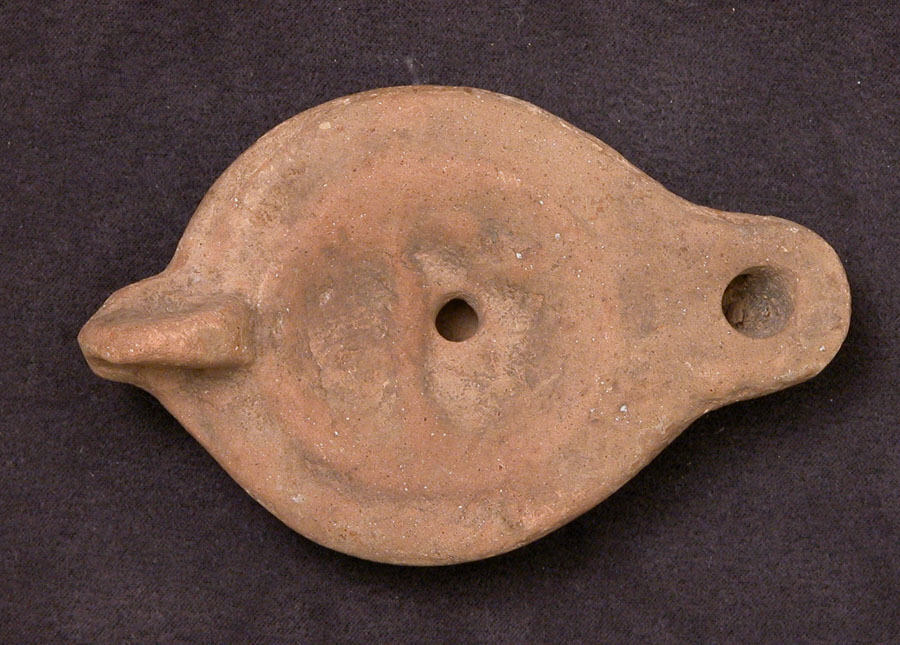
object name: lamp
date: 101-600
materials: earthenware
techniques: molding